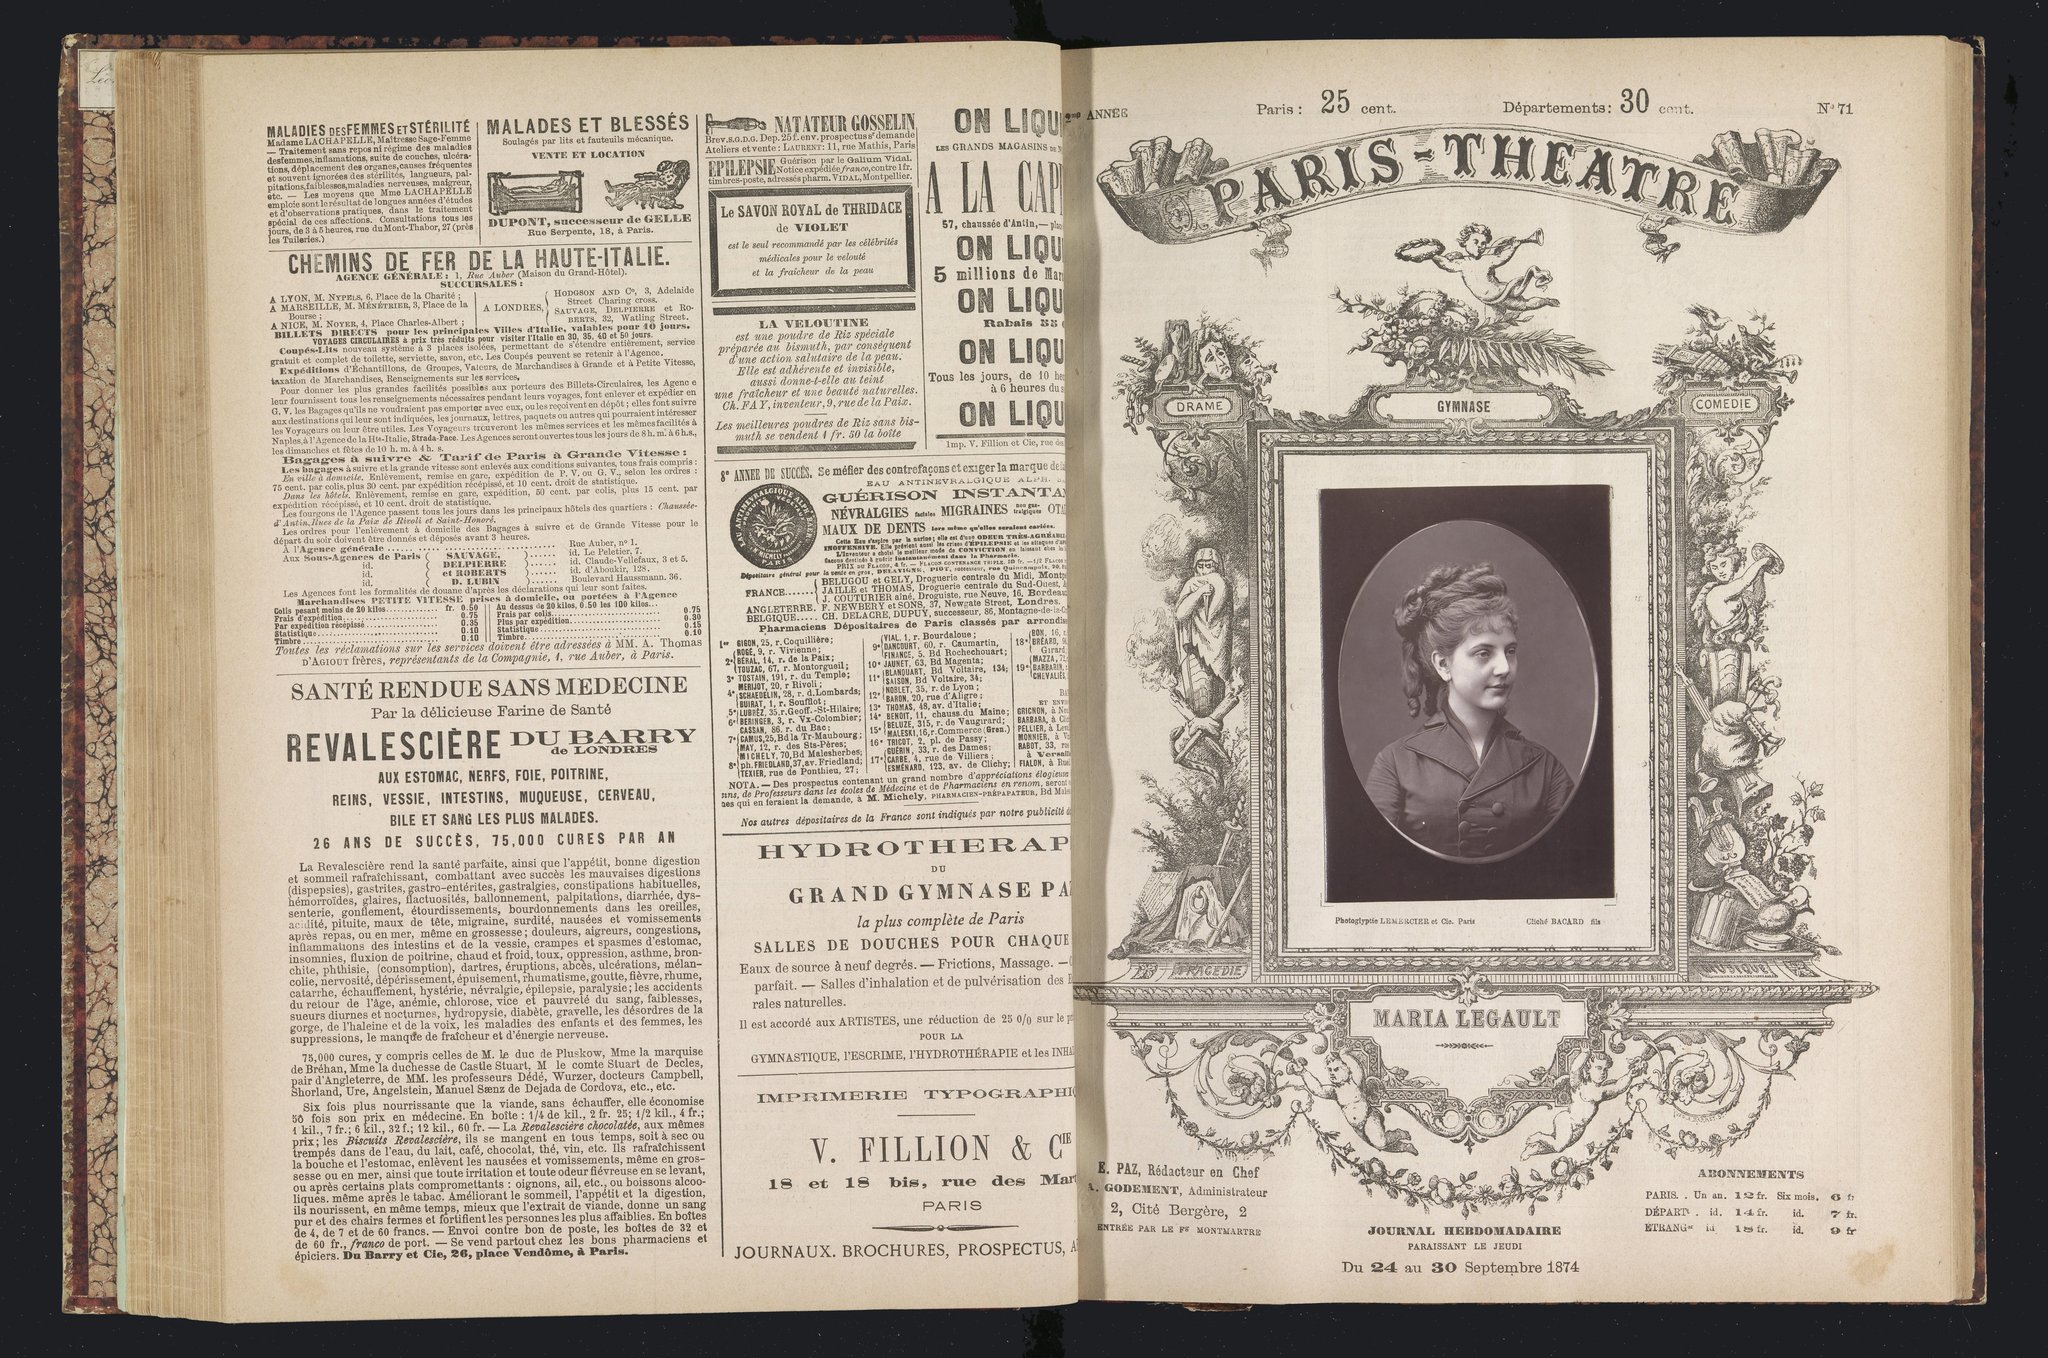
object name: photomechanical print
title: Maria Legault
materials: paper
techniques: woodburytype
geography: paris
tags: portrait of actor, actress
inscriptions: inscription: ‘Journal hebdomadaire paraissant le jeudi Du 24 au 30 Septembre 1874’, number: ‘No 71’